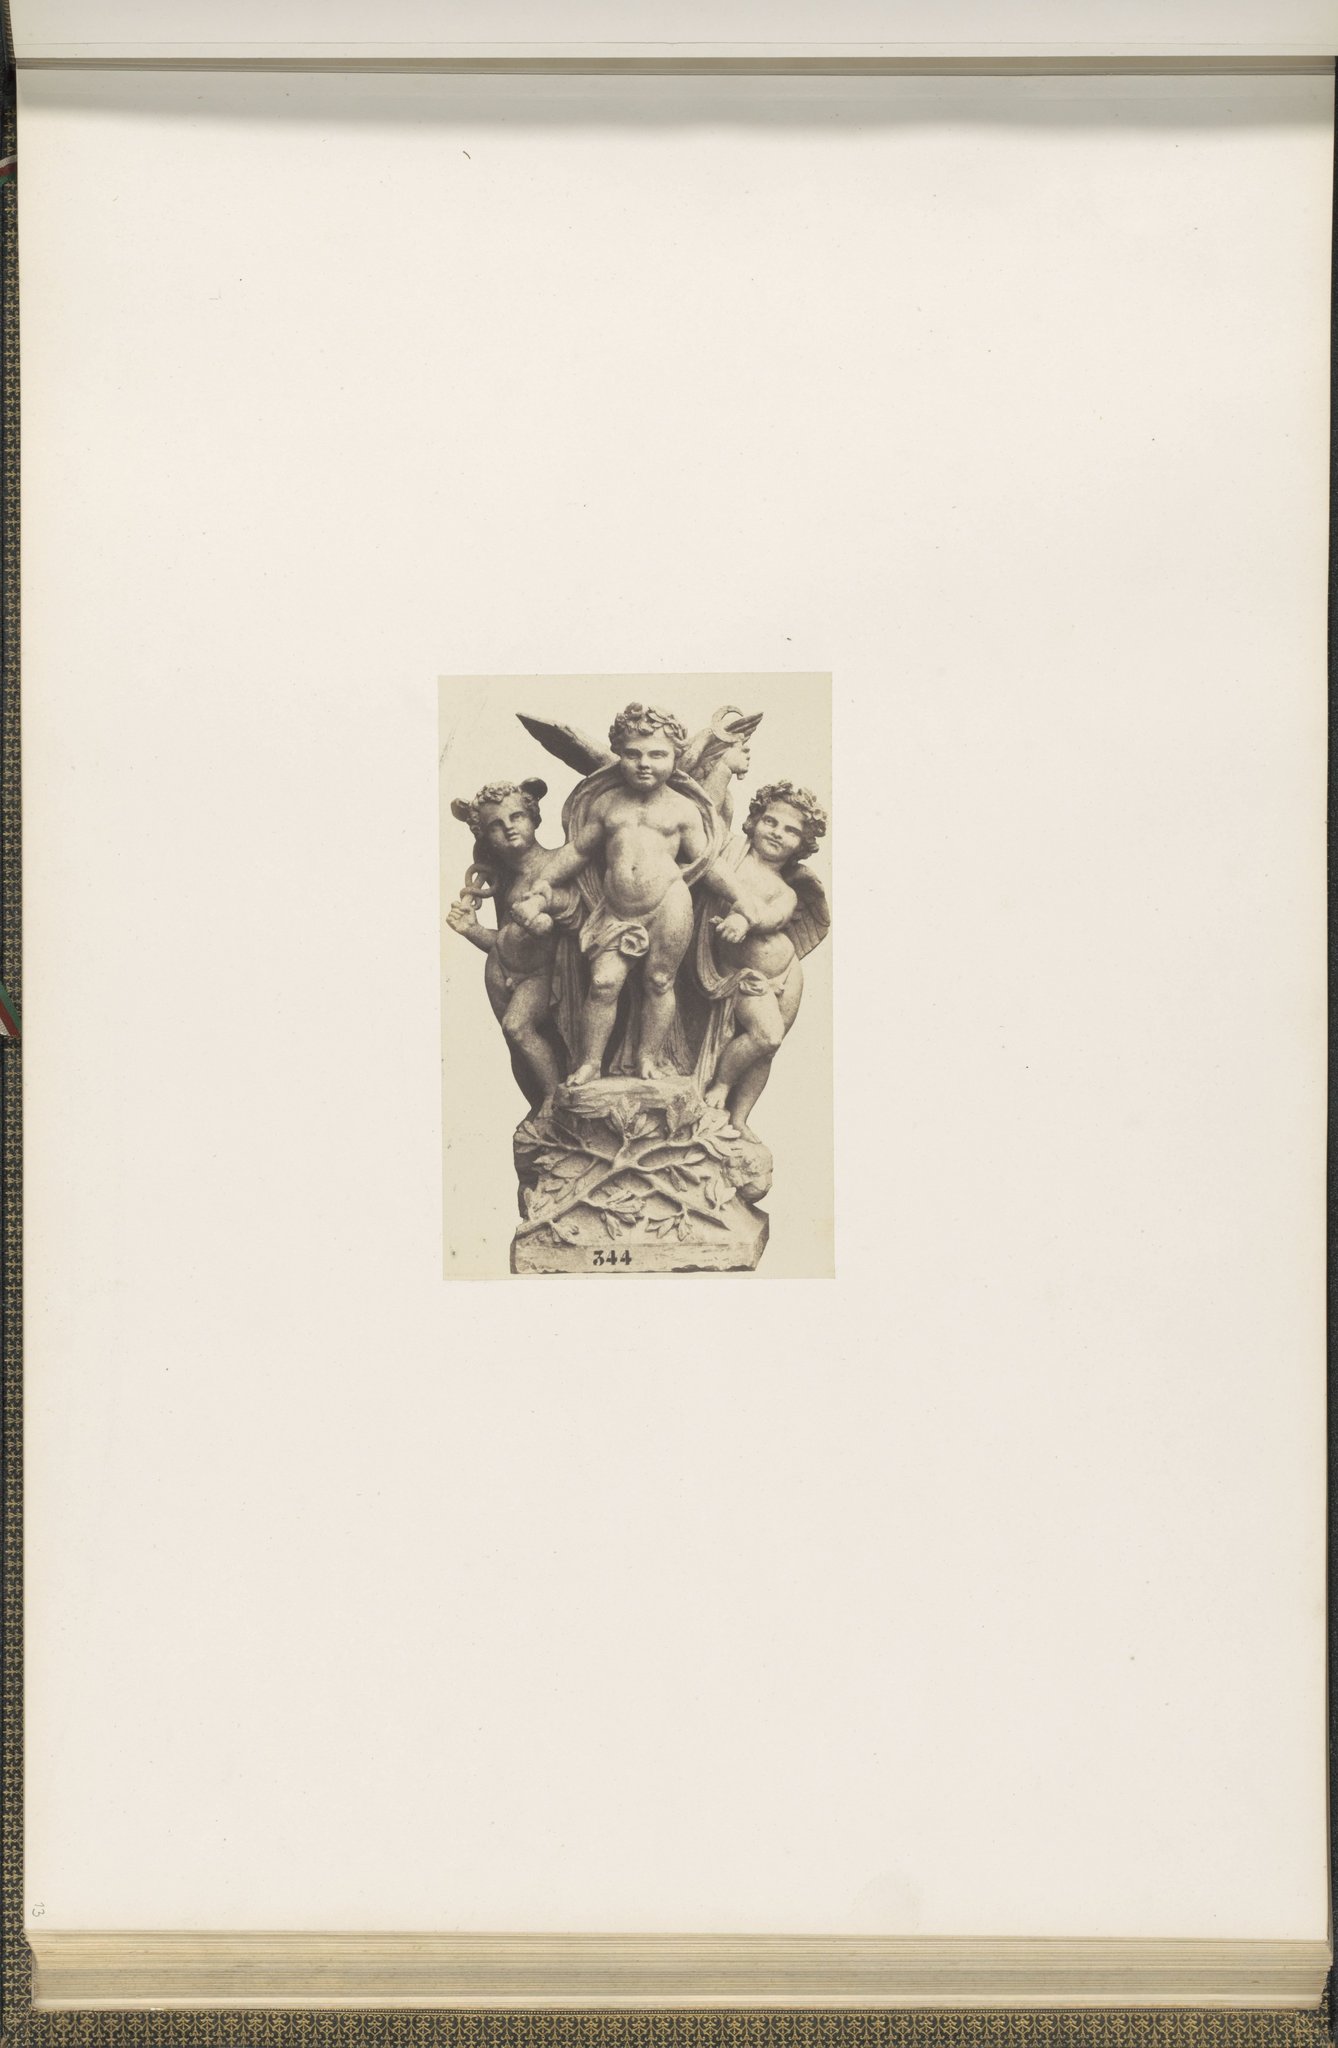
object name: photograph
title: Gipsmodel voor beeldhouwwerk op het Palais du Louvre: "Le Commerce et l'Agriculture" door Louis Léopold Chambard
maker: édouard denis baldus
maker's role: fotograaf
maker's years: 1813-1889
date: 1855-1857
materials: paper, photographic support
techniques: salted paper print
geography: paris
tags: piece of sculpture, reproduction of a piece of sculpture, permanent exhibition, museum, paris, tuileries palace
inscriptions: number: ‘344’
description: Onderdeel van Réunion des Tuileries au Louvre 1852-1857, album 4.